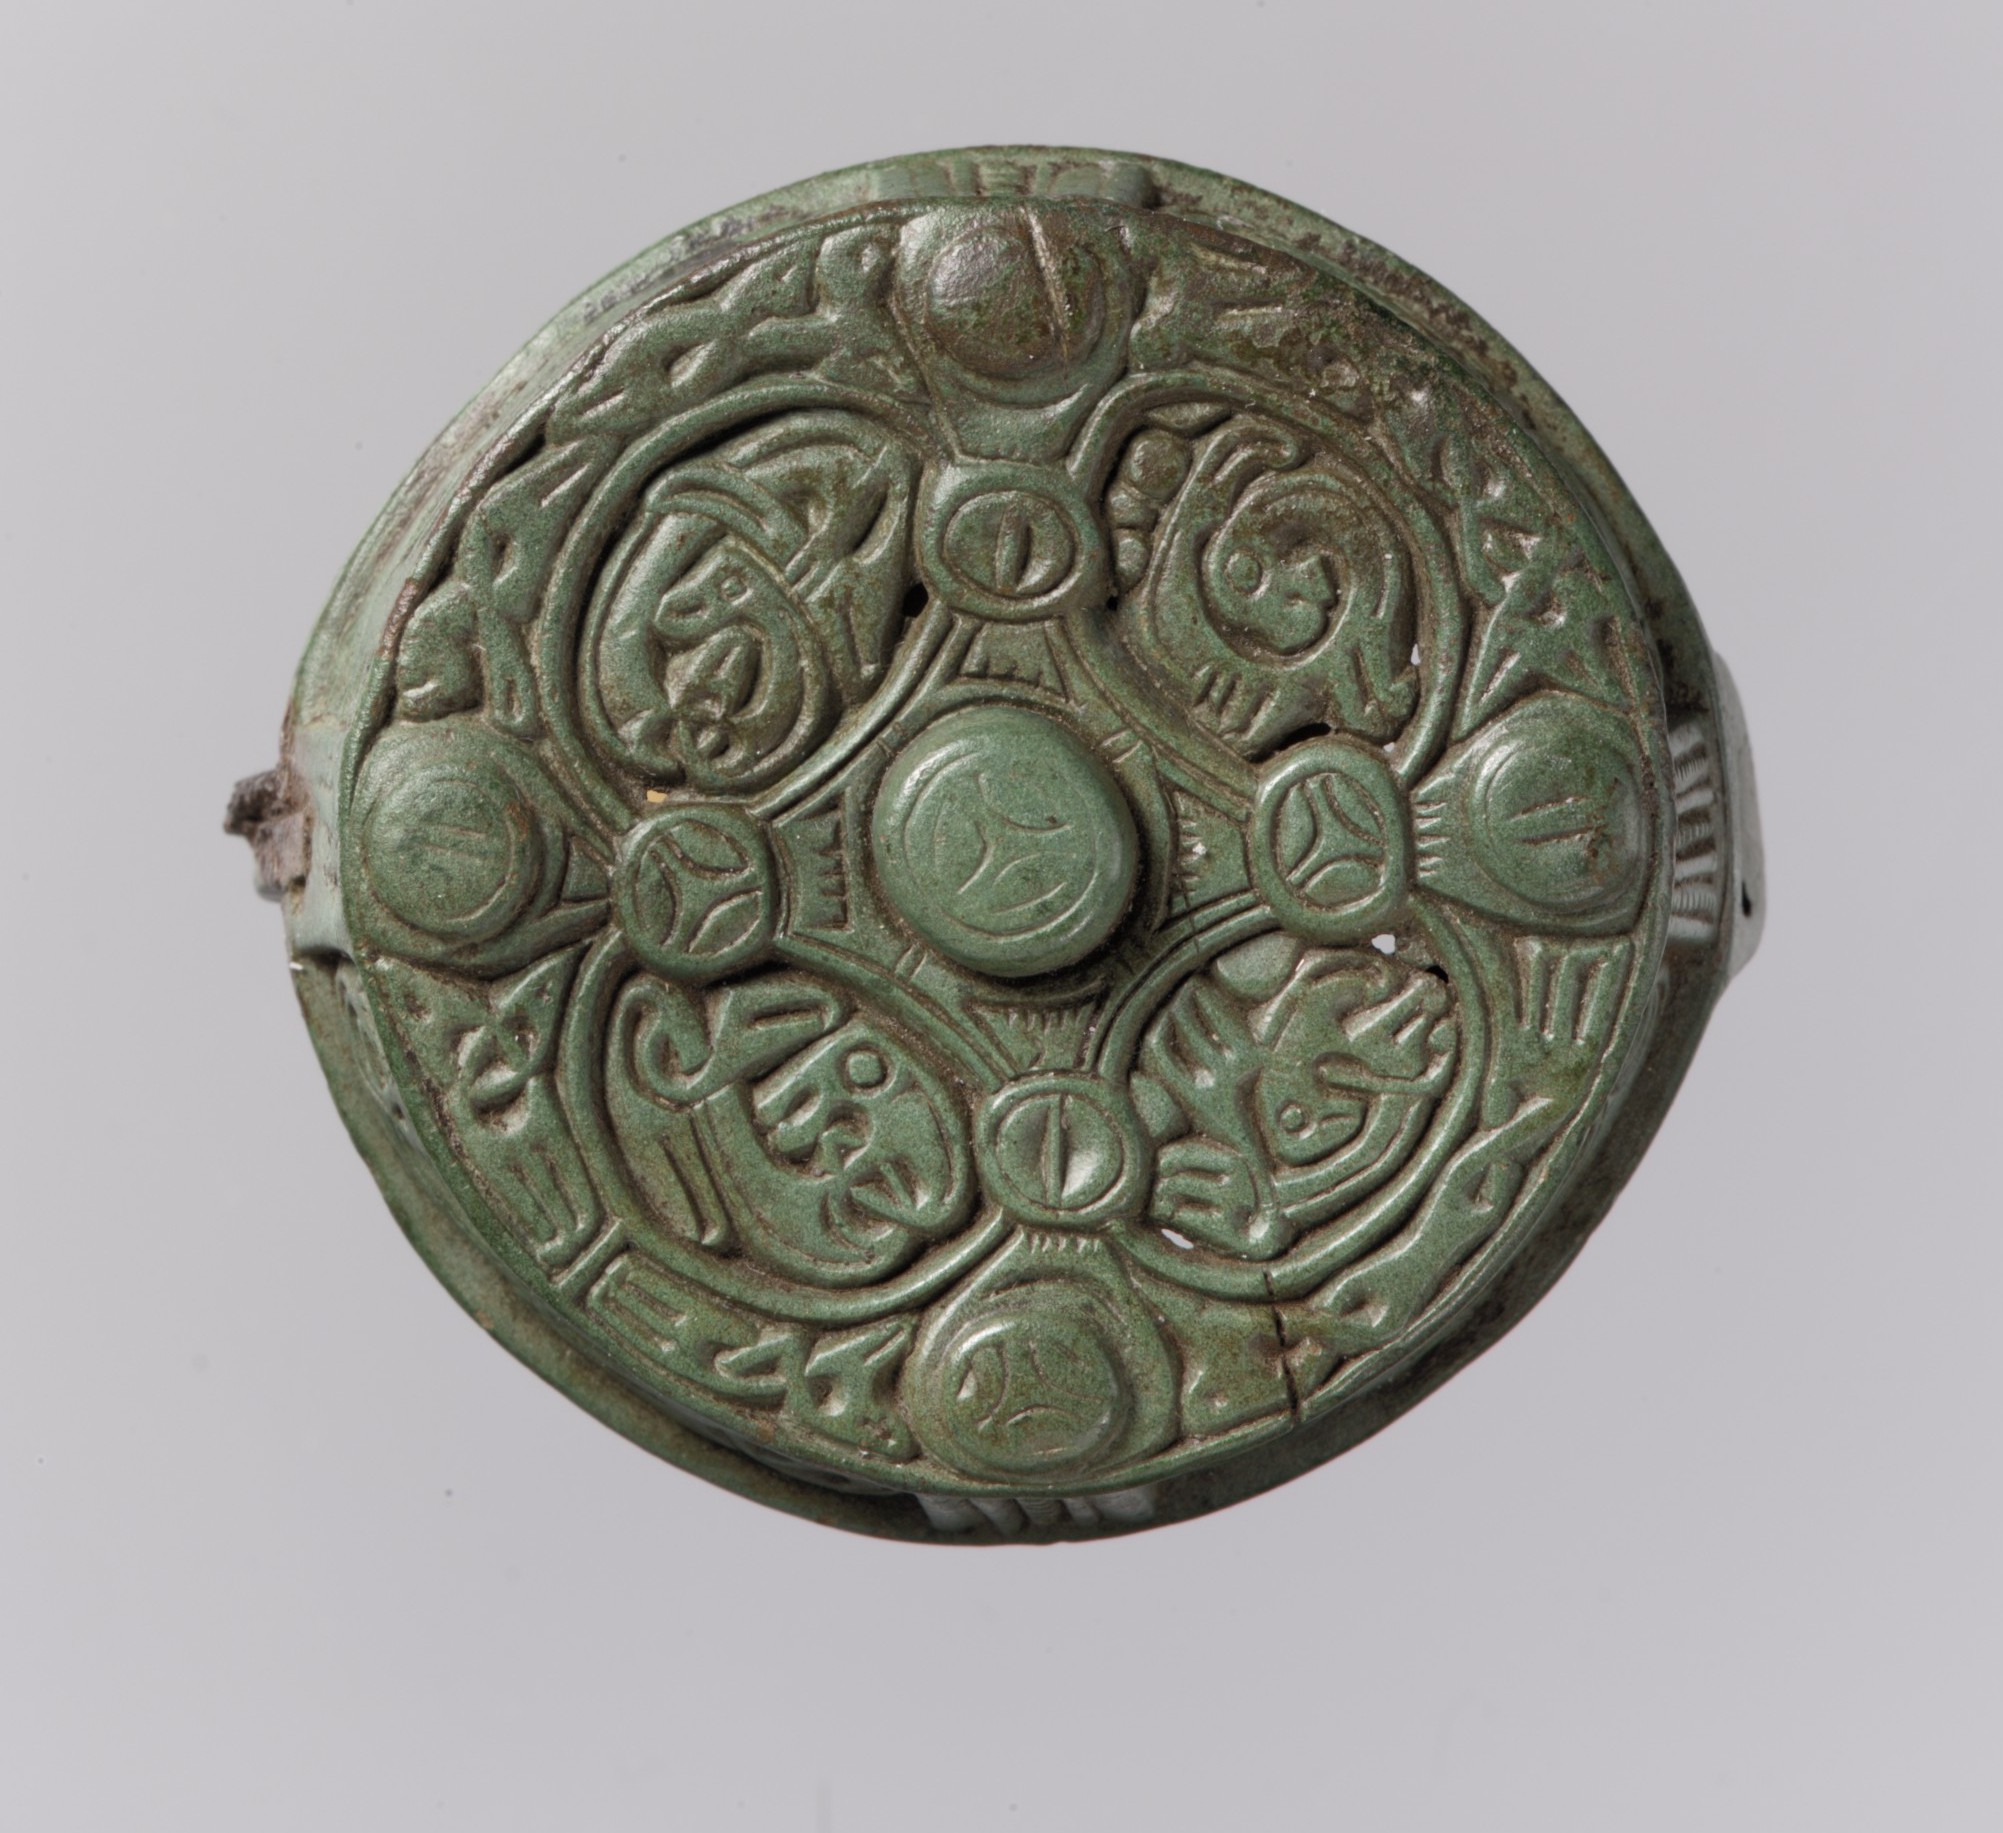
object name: brooch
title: Round Box Brooch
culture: viking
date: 700-900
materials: copper alloy, iron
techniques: casting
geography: sweden